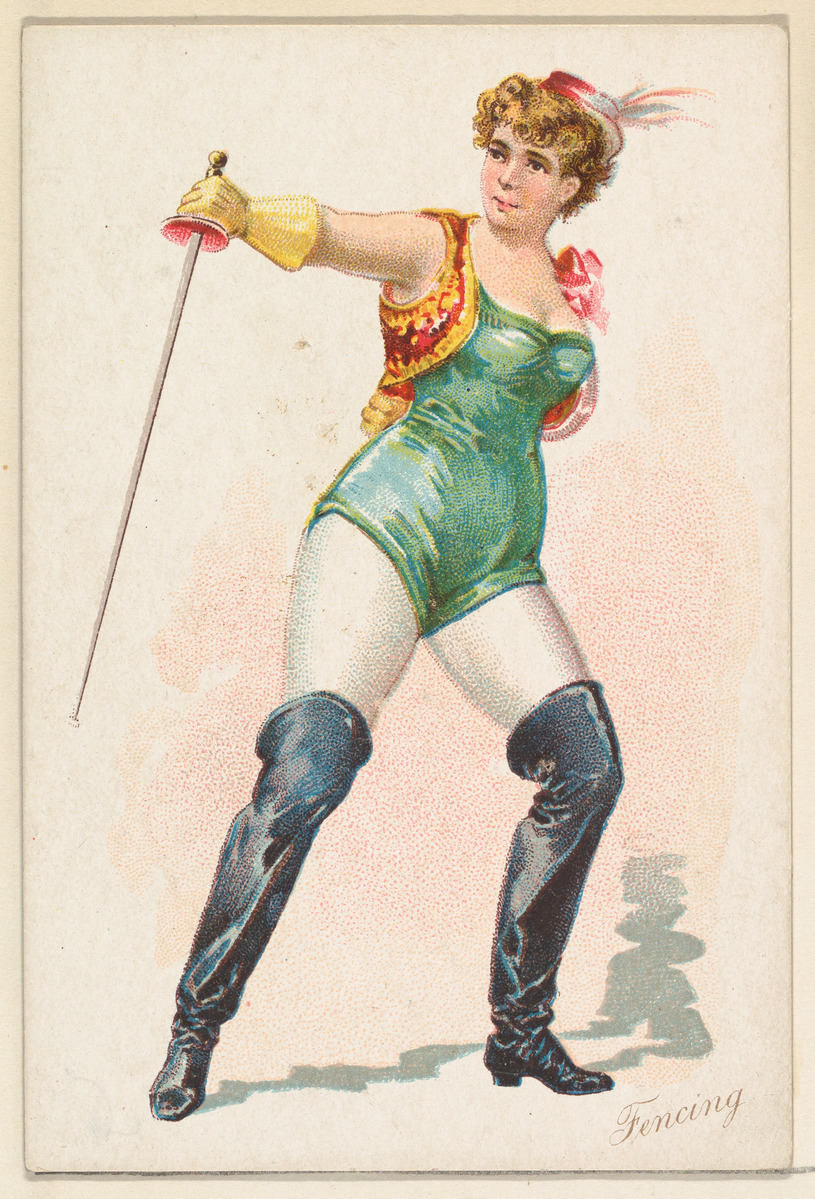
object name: print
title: Fencing, from the Pretty Athletes series (N196) issued by Wm. S. Kimball & Co.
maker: william s. kimball & company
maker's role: publisher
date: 1889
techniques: color lithograph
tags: women,fencing